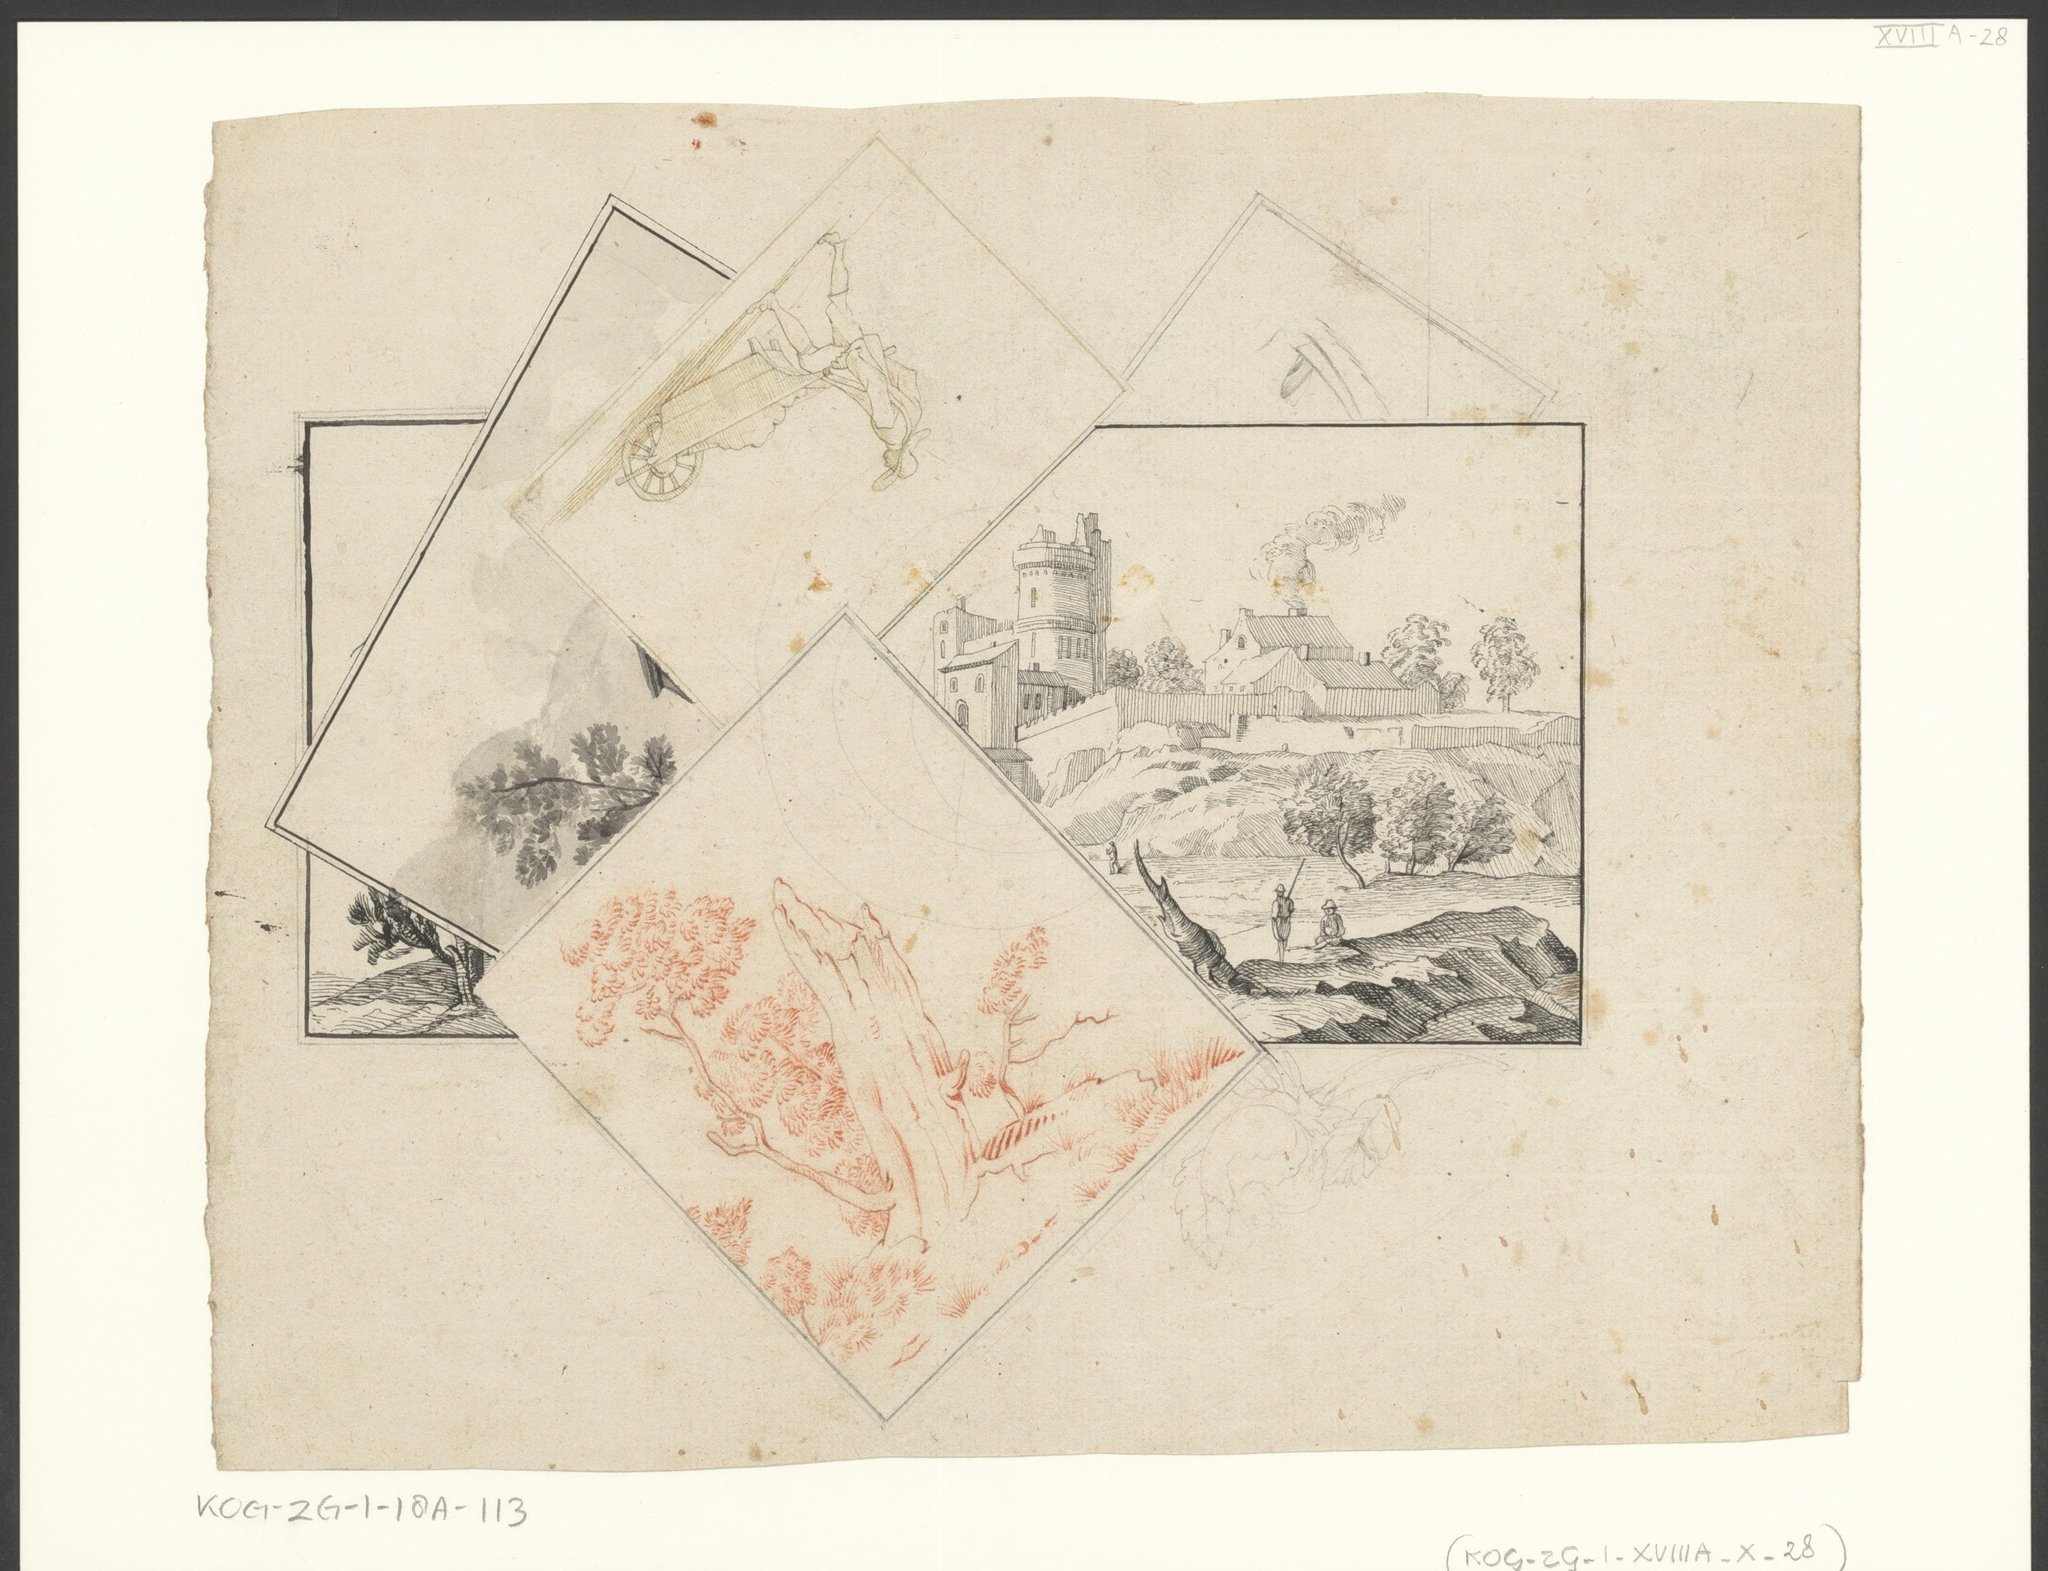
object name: drawing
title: Schijnbedrieger met boomstam, gezicht op een kasteel en een man met een kruiwagen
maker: Anonymous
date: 1800-1899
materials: chalk, ink, paper, pencil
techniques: brush, pen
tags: 'trompe l'oeil', drawing, sketch, print, e.g.: engraving, etching, lithograph, playing-cards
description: Schijnbedrieger met boomstam, gezicht op een kasteel en een man met een kruiwagen. Onderwerpsrubrieken binnen de Atlas Zeden en Gewoonten: Schoone kunsten, Schijnbedriegers.